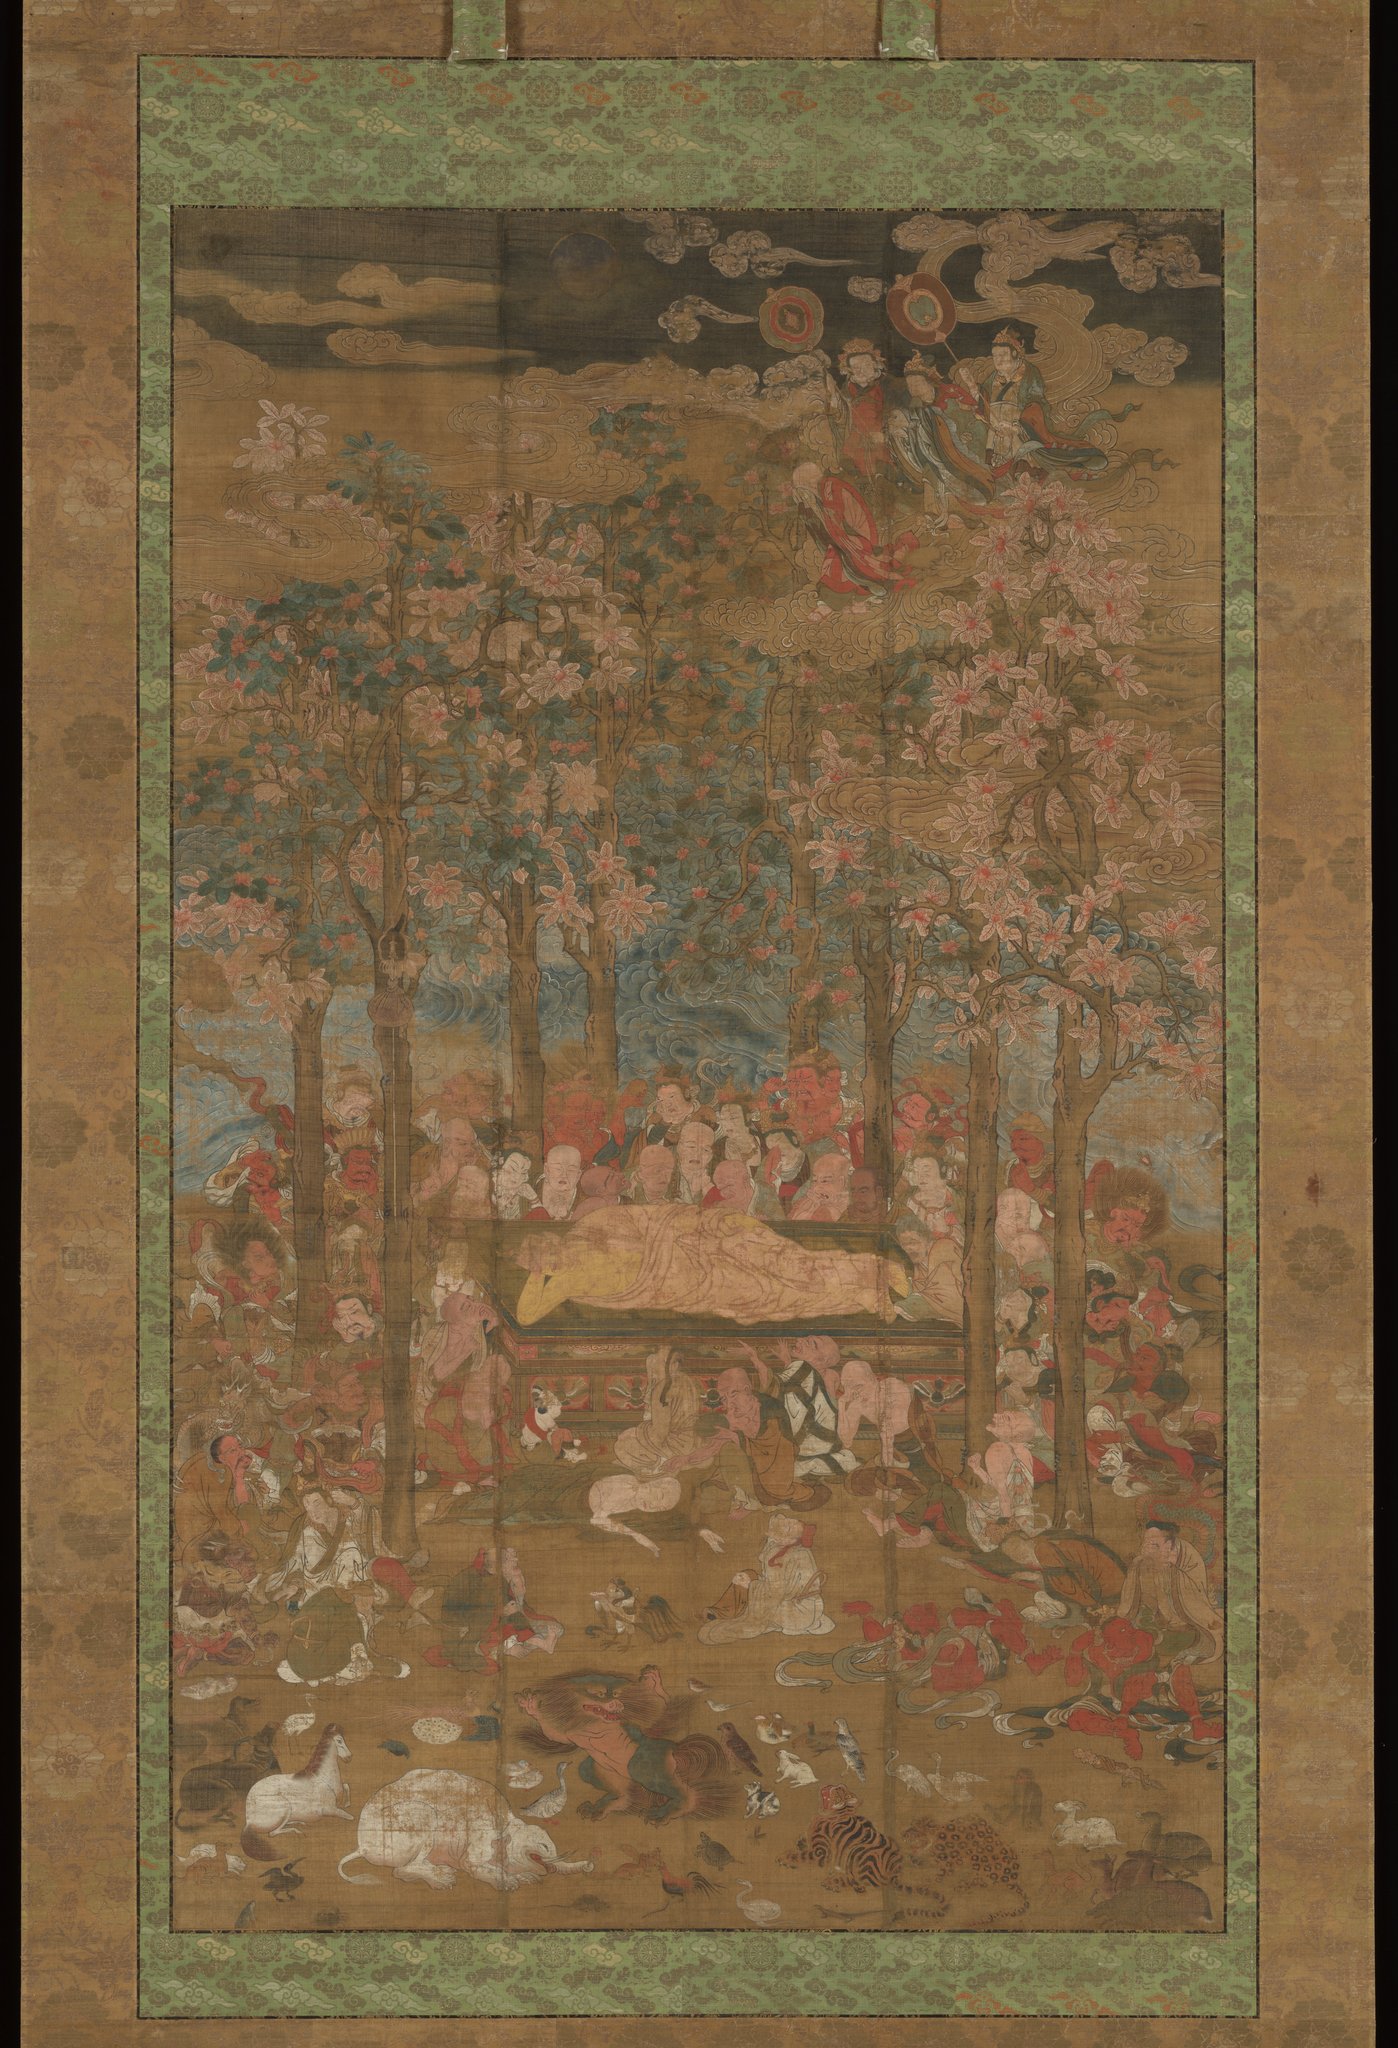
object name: hanging scroll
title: Death of the Historical Buddha (Nehan-zu)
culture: japanese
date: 1401-1500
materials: gold, ink, silk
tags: human figures,animals,sadness,elephants,buddha,death